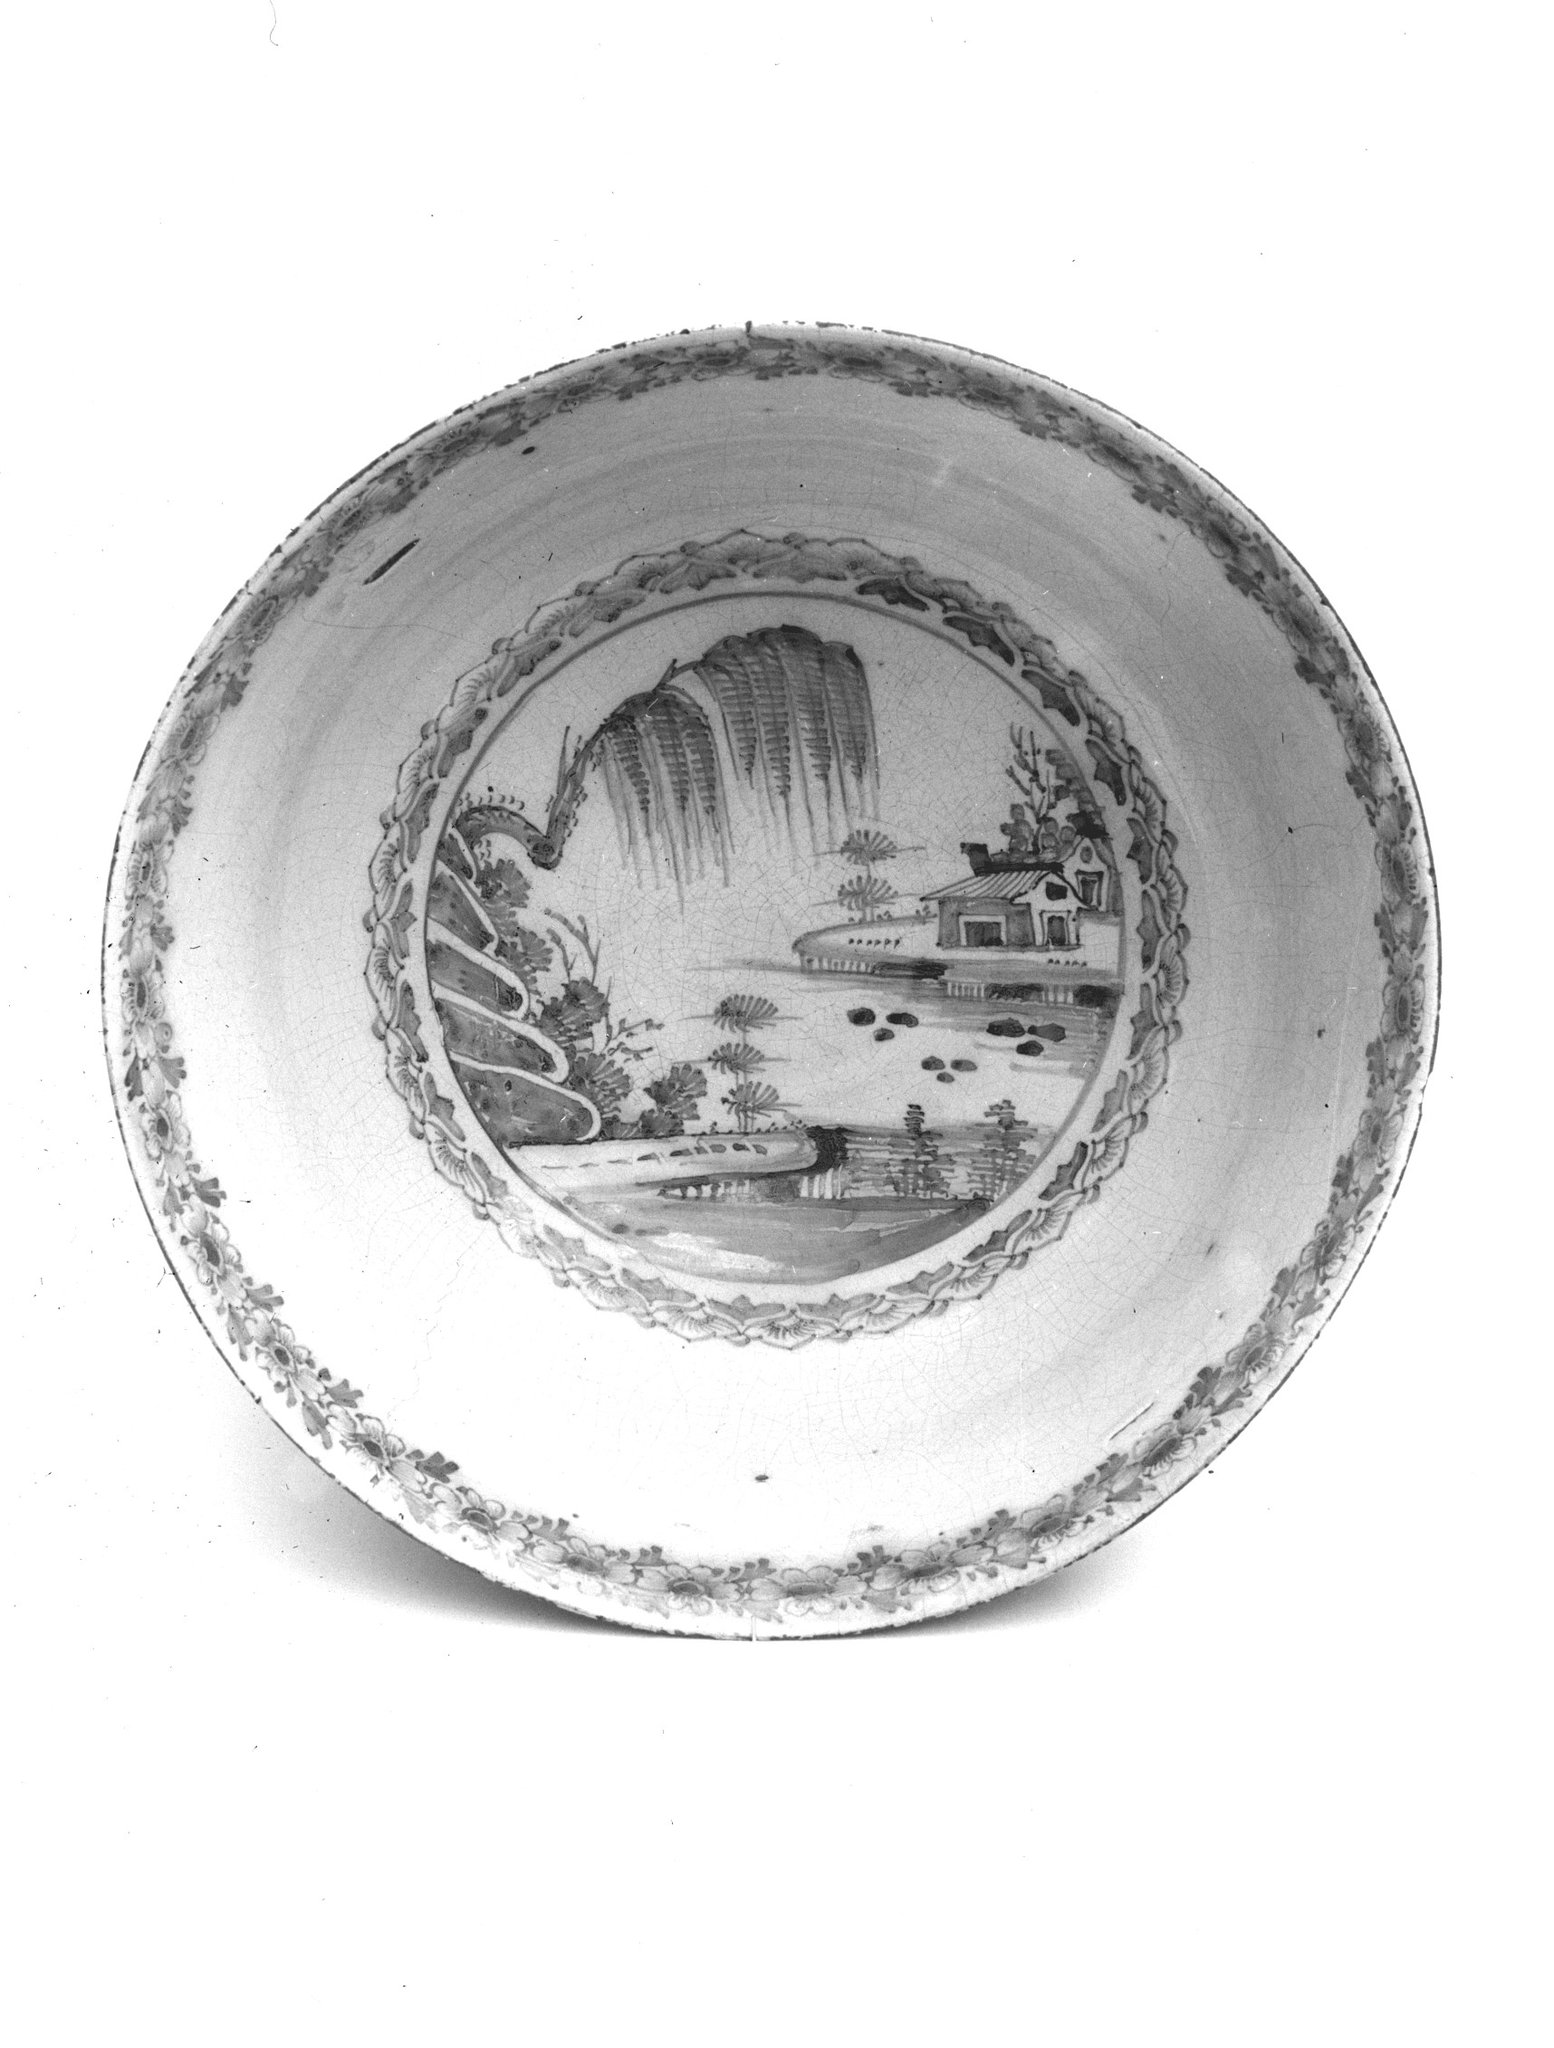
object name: bowl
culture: british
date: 1750-1760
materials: earthenware, tin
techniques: enamel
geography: england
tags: landscapes